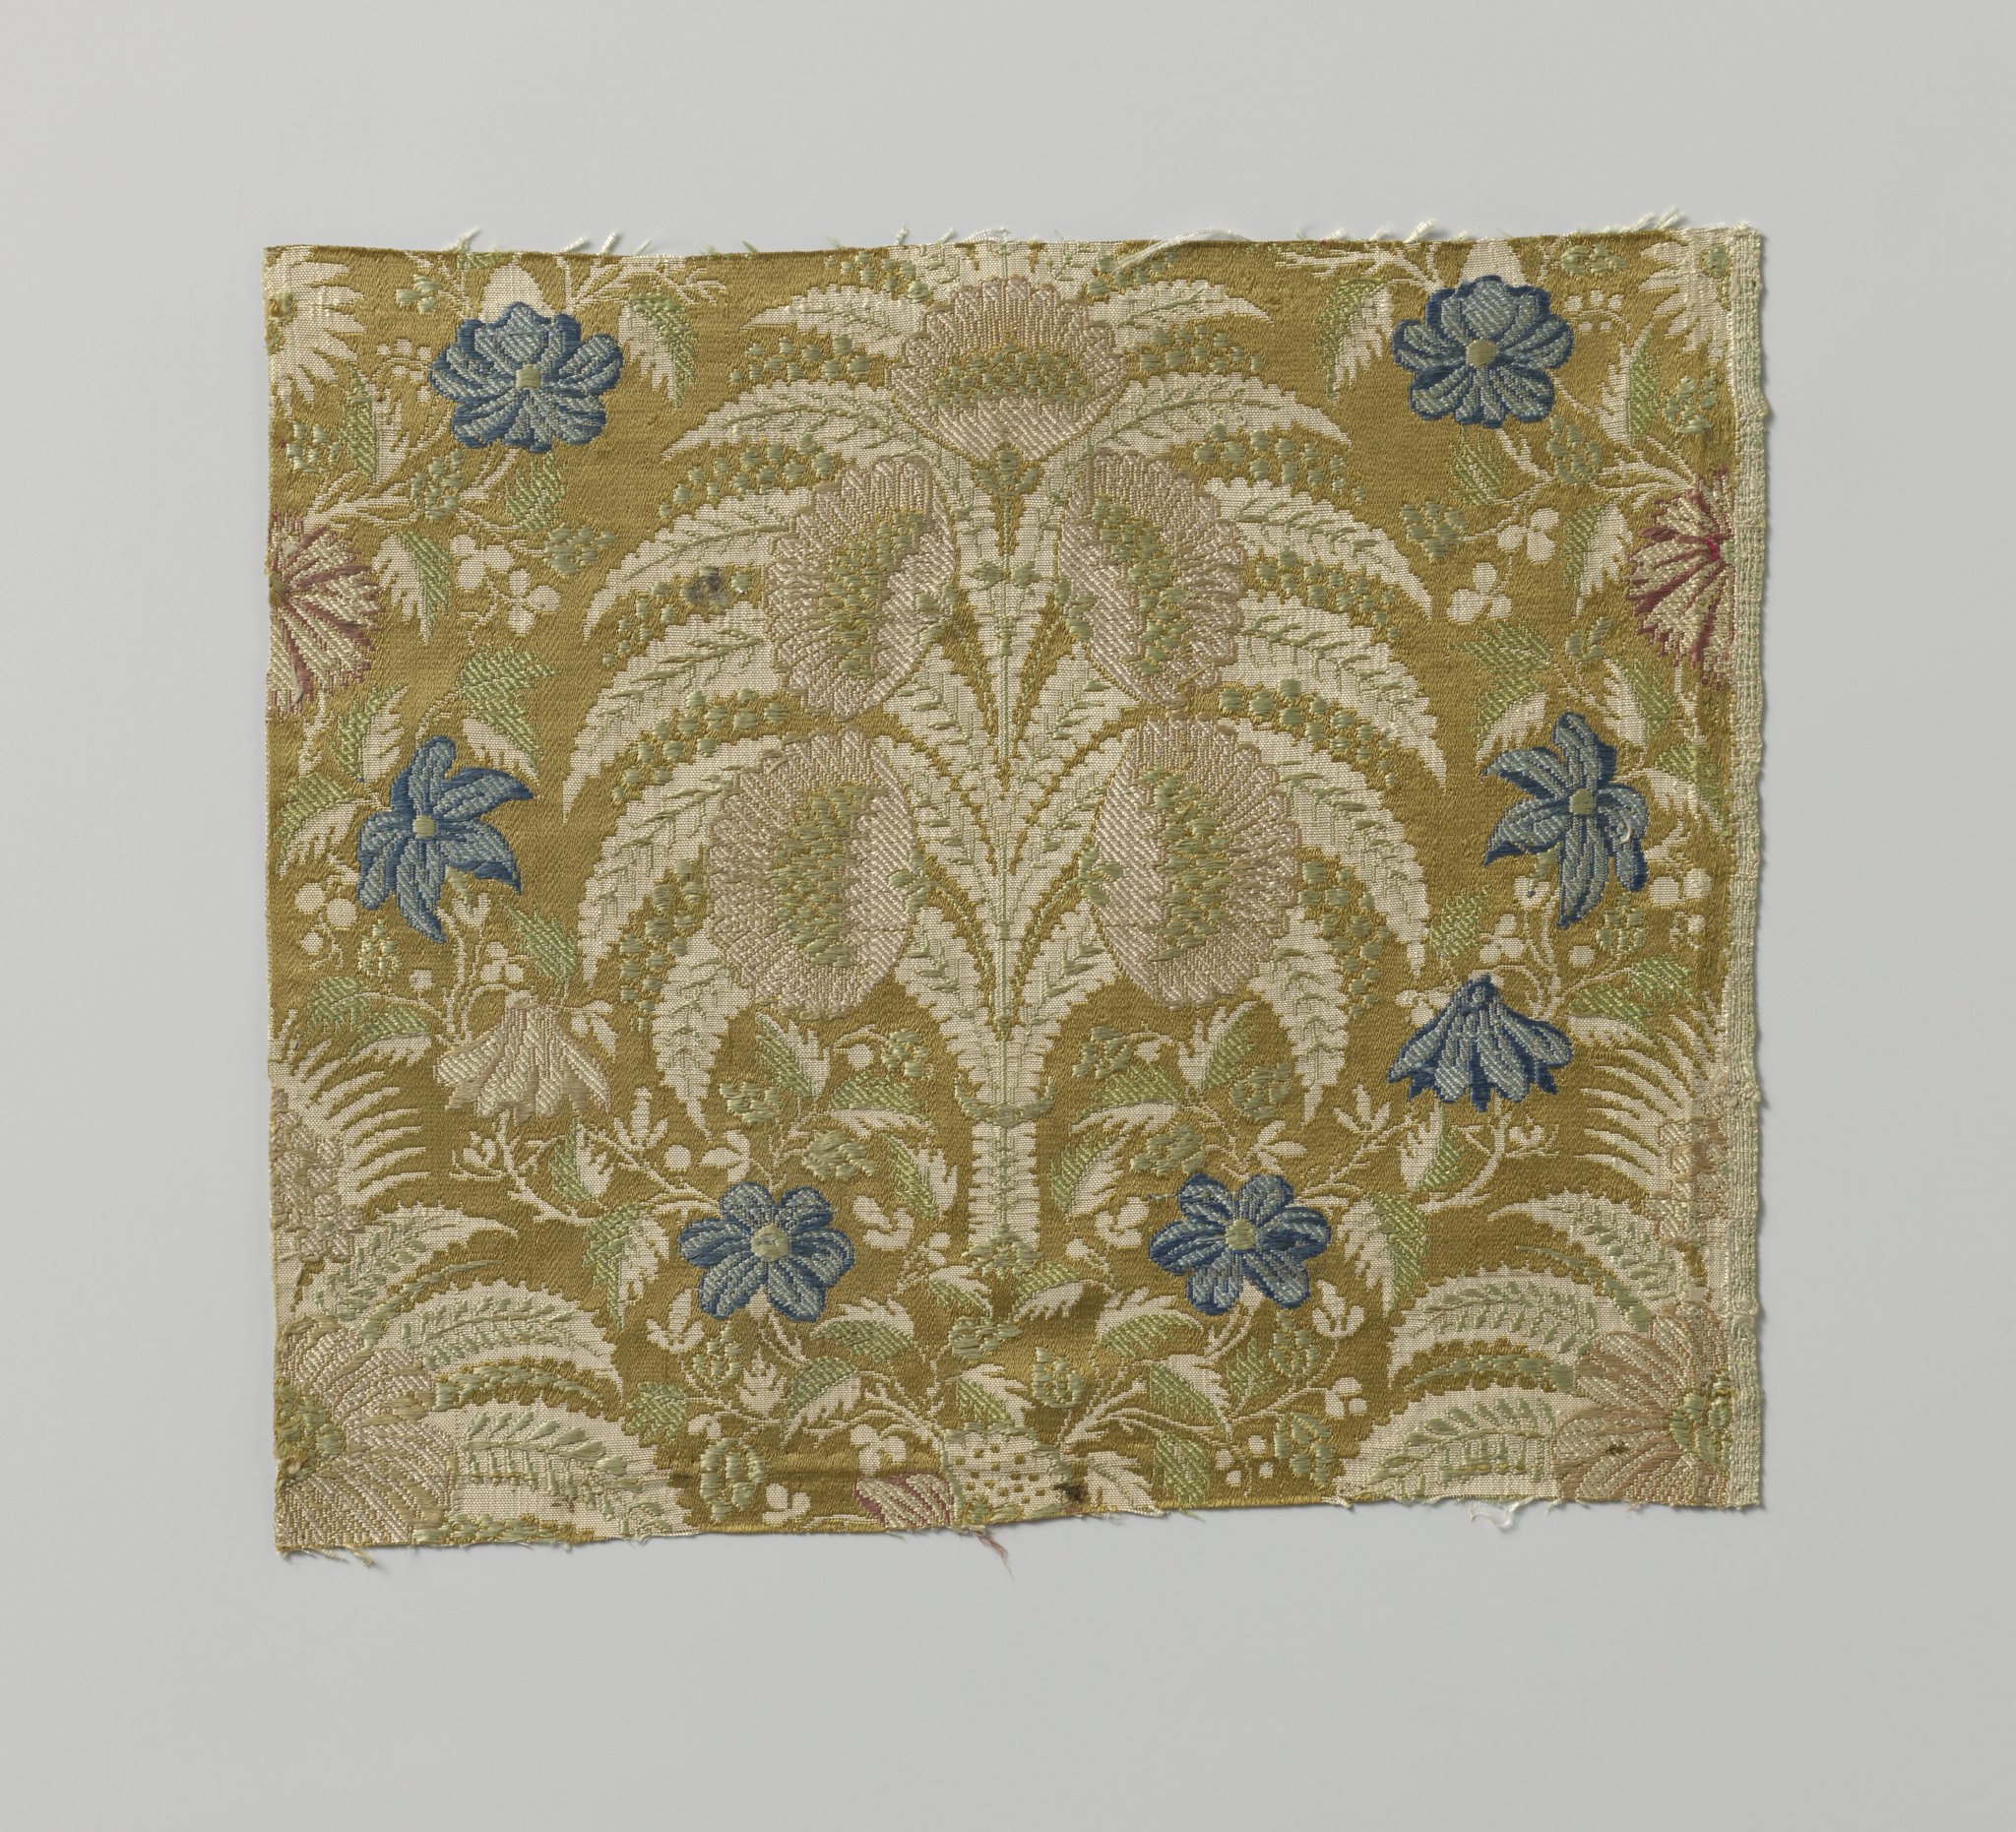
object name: fragment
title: Fragment bruin-gele zijde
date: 1690-1710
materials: silk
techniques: brocade, lampas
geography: netherlands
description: Fragment bruin-gele zijde met patroon van een tak met lancetvormige bladeren met vijf bloemen omgeven door een bladkrans met blauwe bloemen.